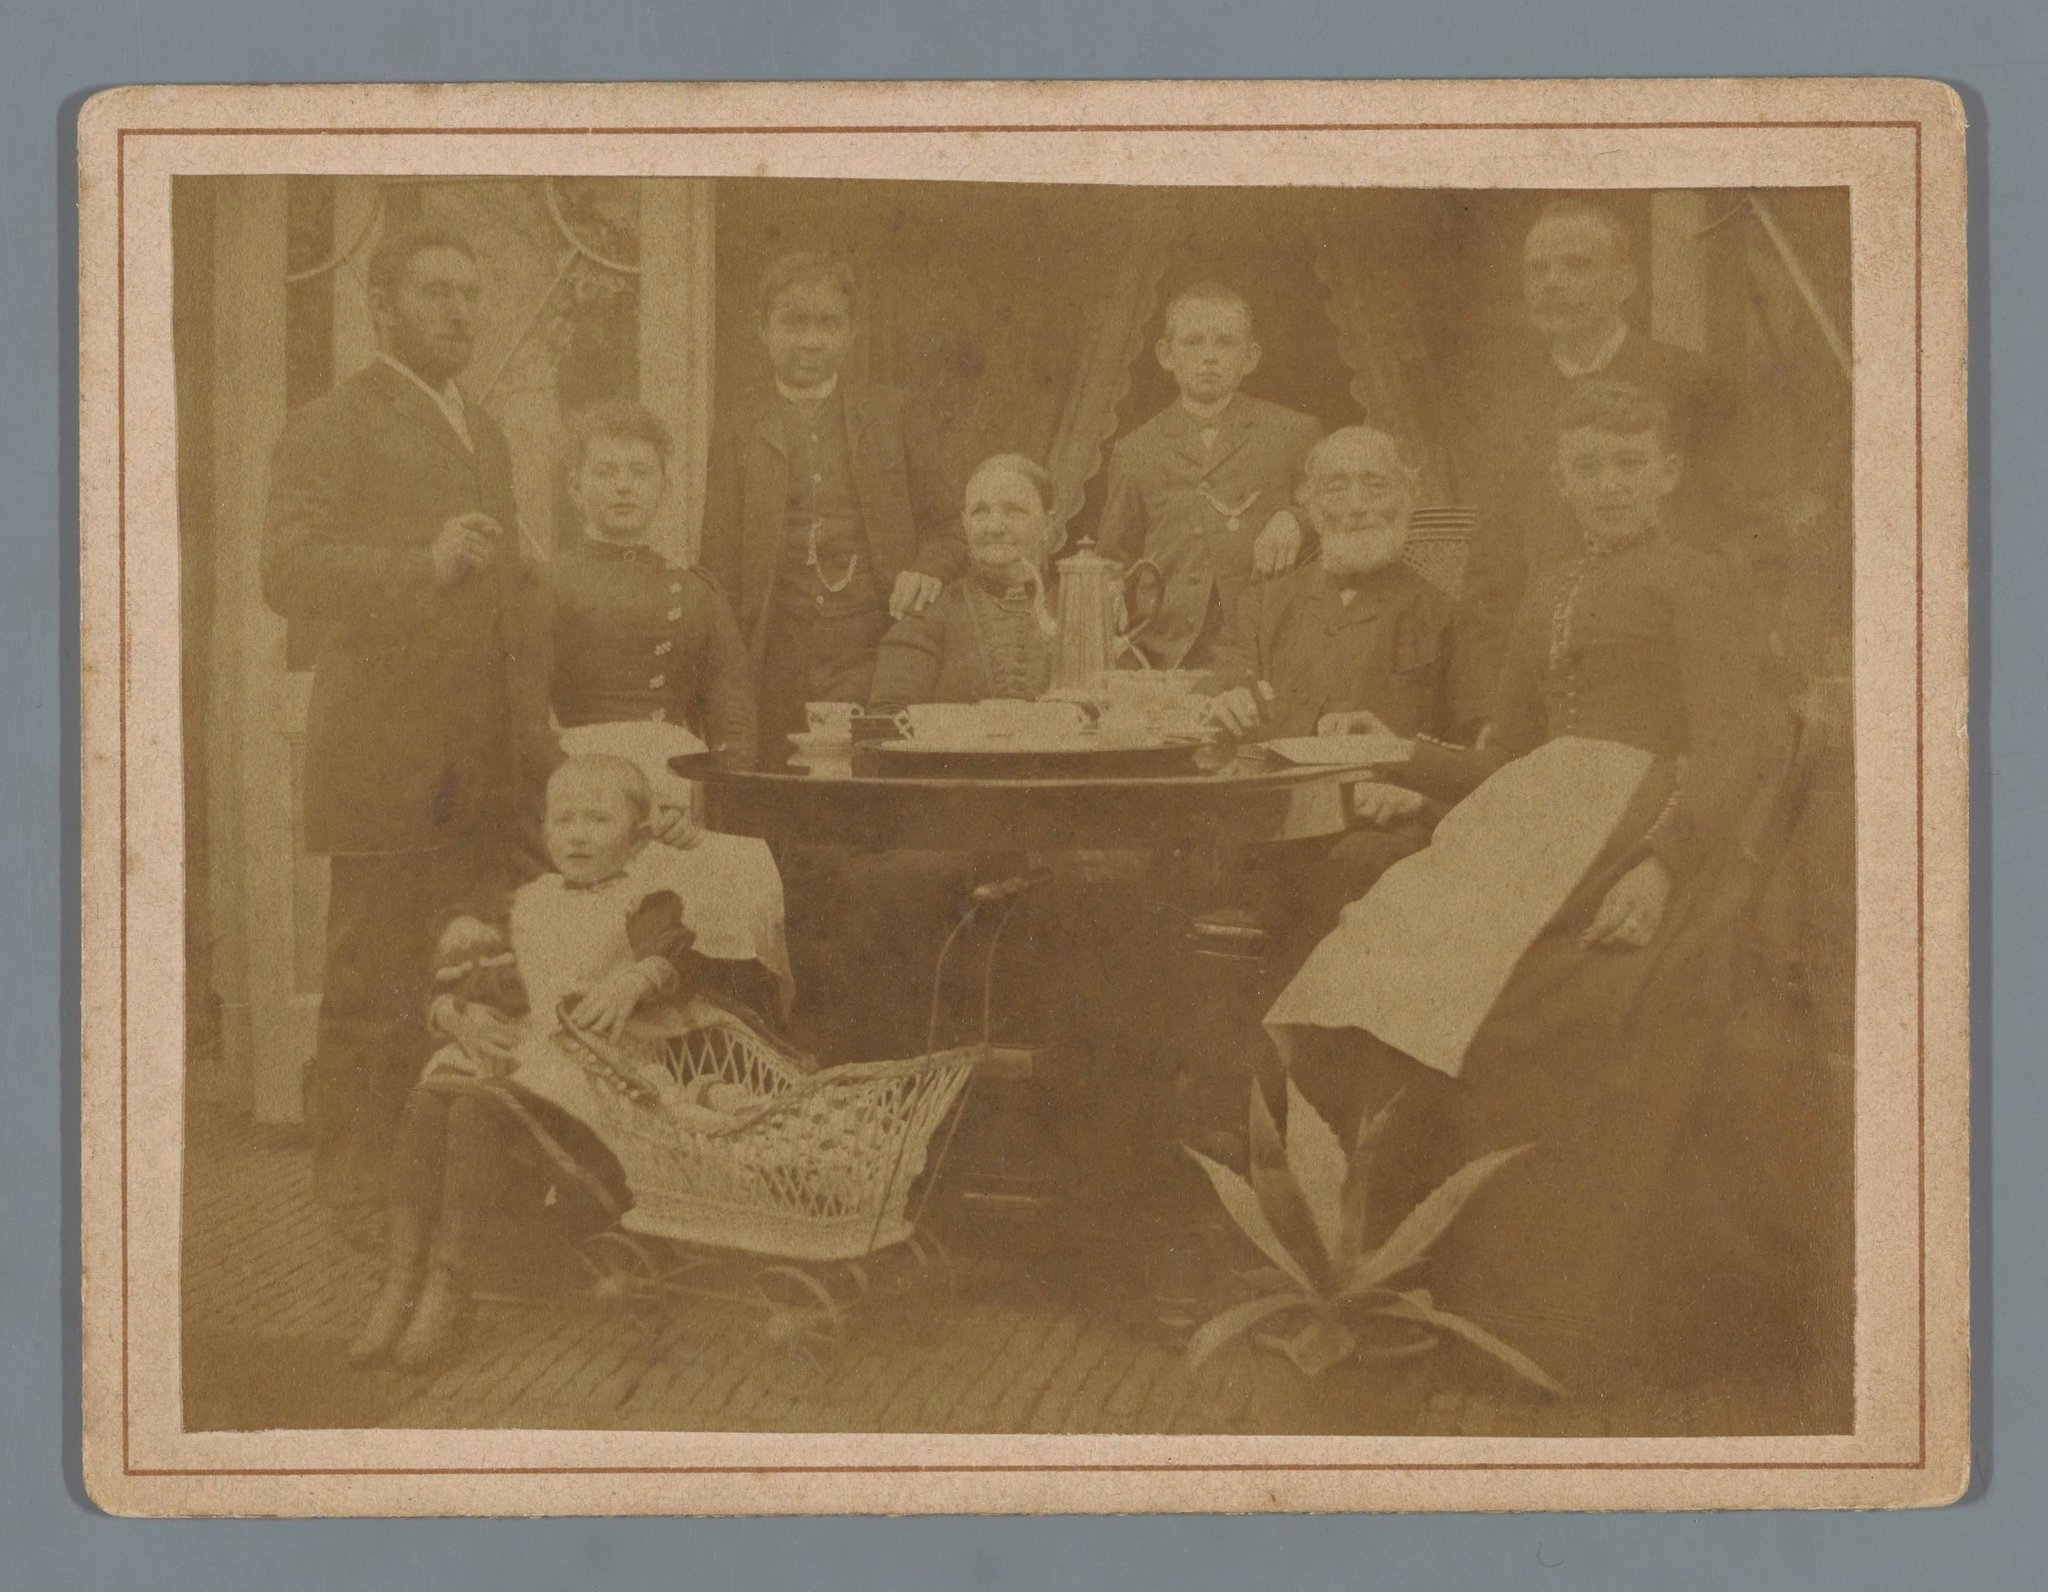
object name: photograph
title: Groepsportret van een onbekende familie rond een tafel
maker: Anonymous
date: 1890-1900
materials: cardboard, photographic support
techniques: albumen print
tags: family group, especially parents with their child(ren), table, interior ~ representation of a building